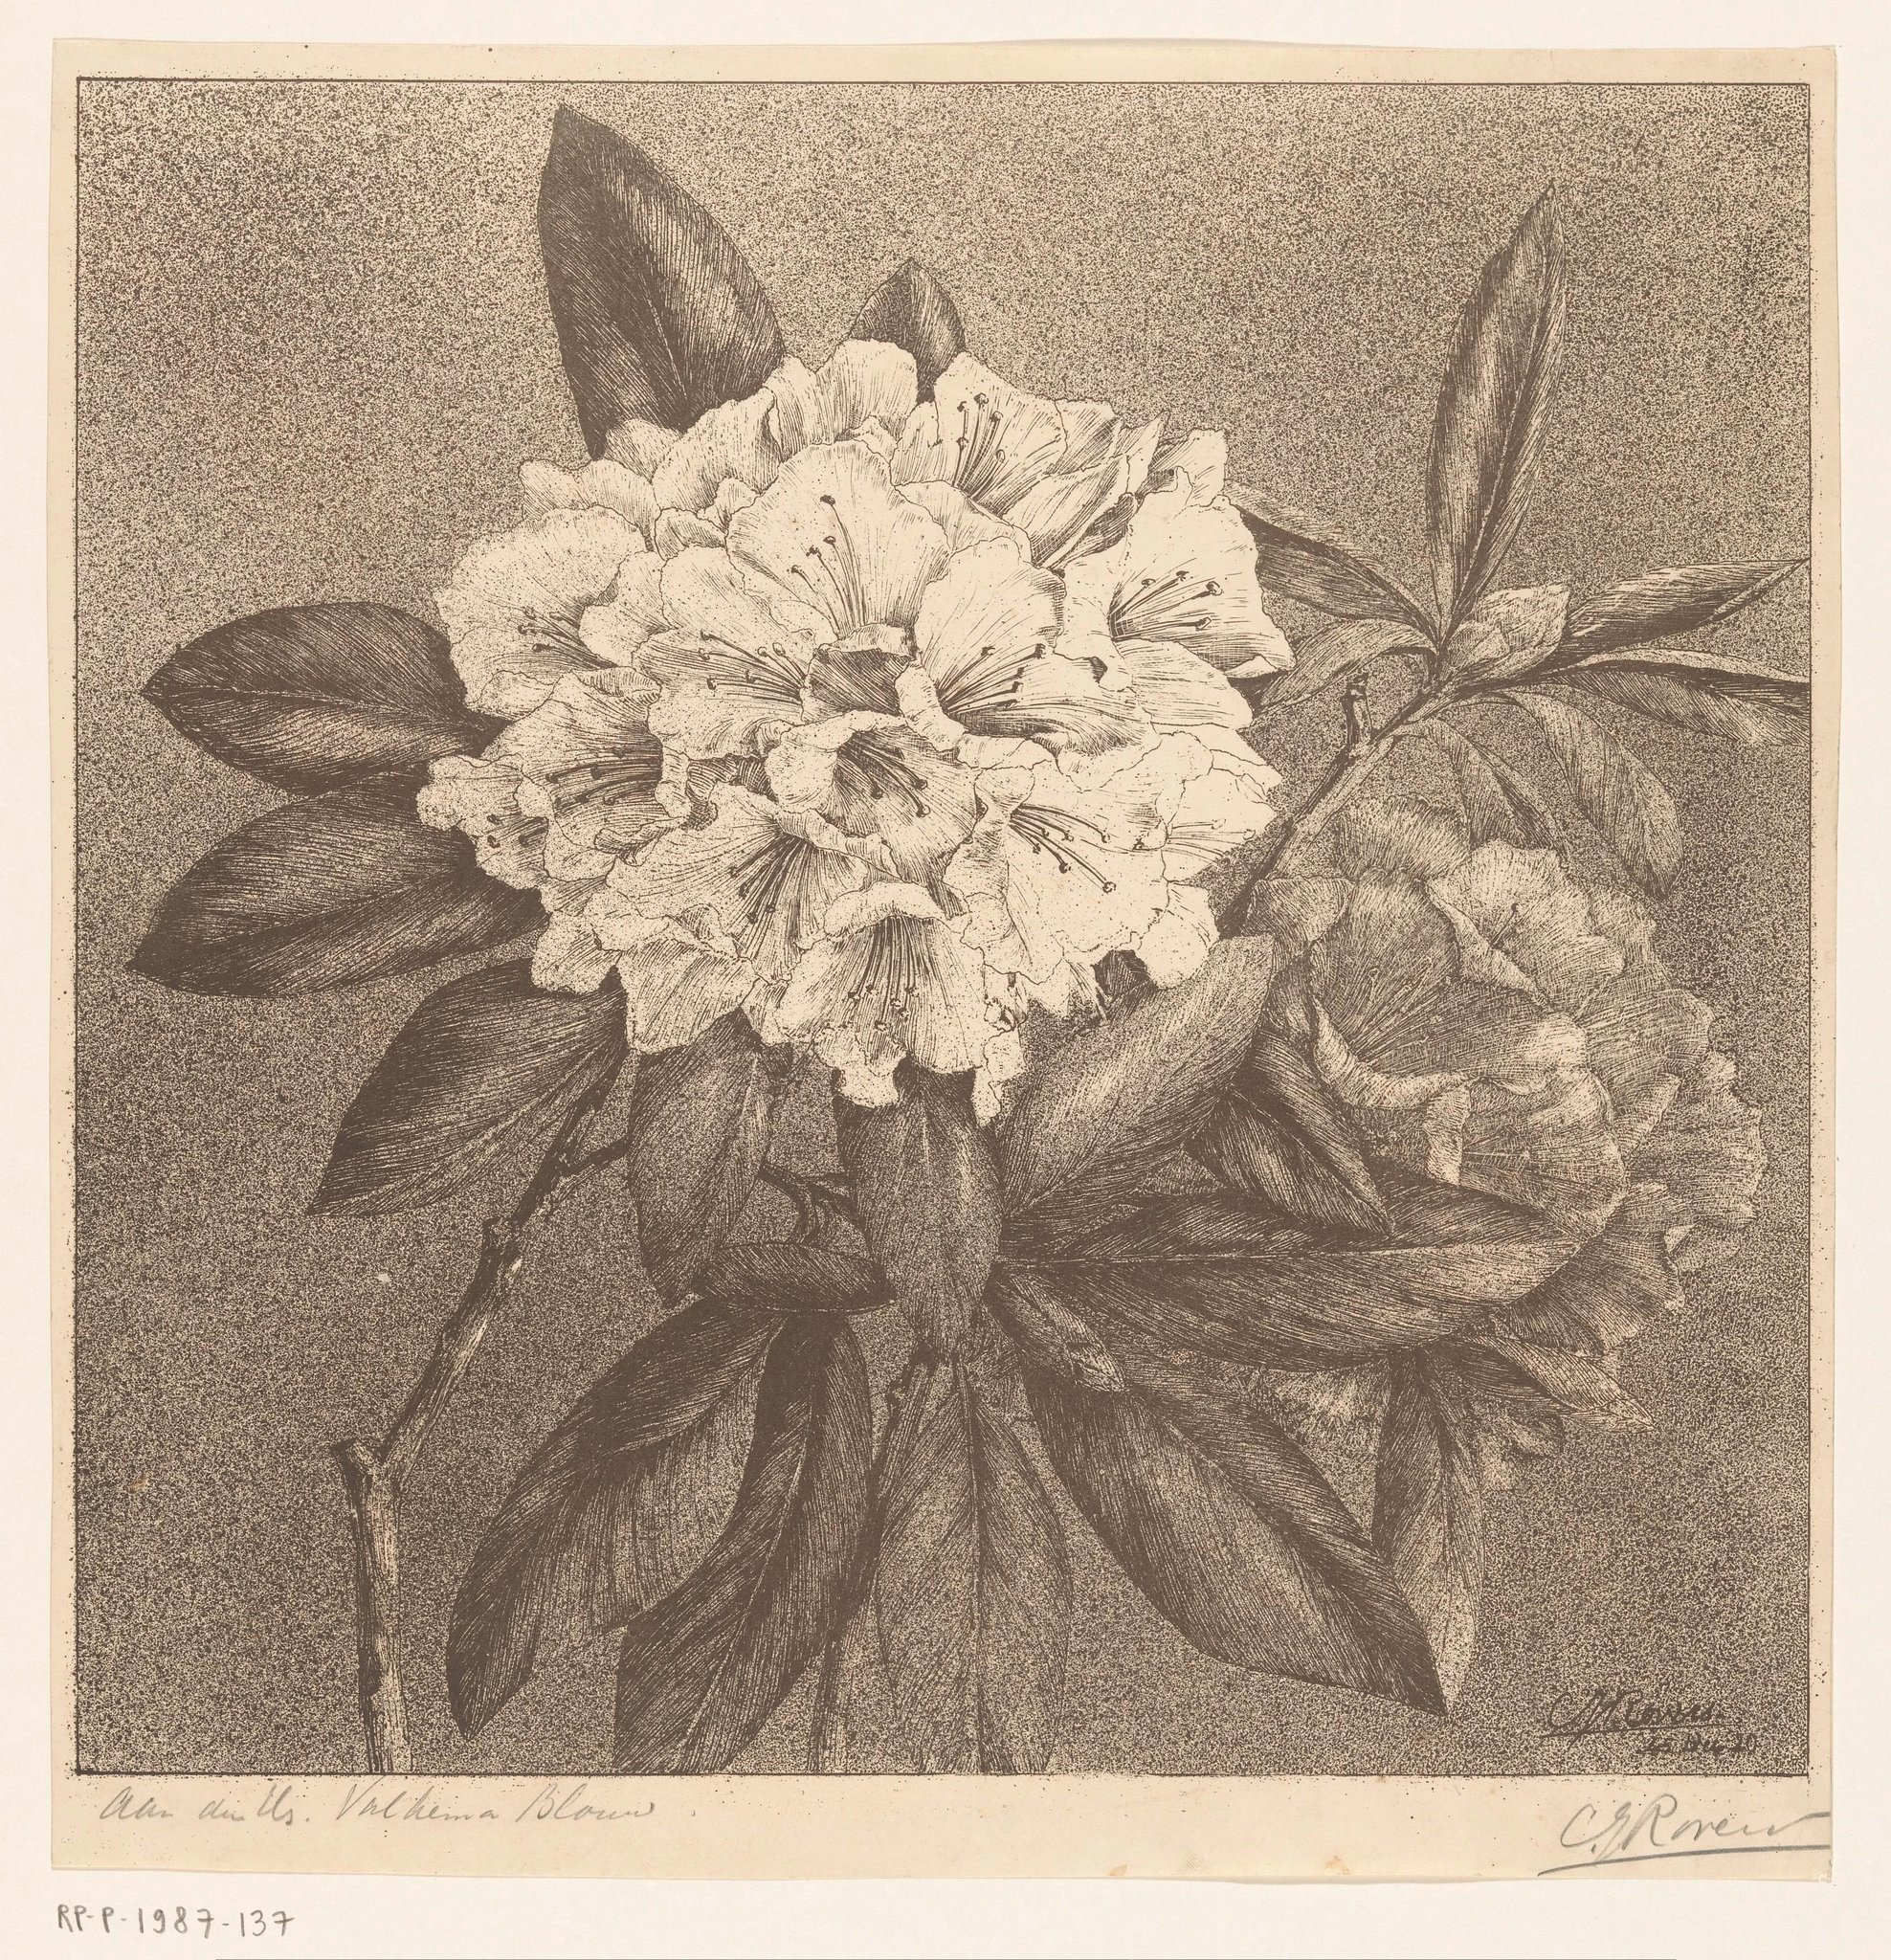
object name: print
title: Rododendron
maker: c.j. rovers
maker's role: print maker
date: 1912-1920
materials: paper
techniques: lithograph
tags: flowers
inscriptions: collector's mark: Lugt 2760, inscription: ‘aan den [...] Valkema Blouw’, collector's mark: Lugt 2228